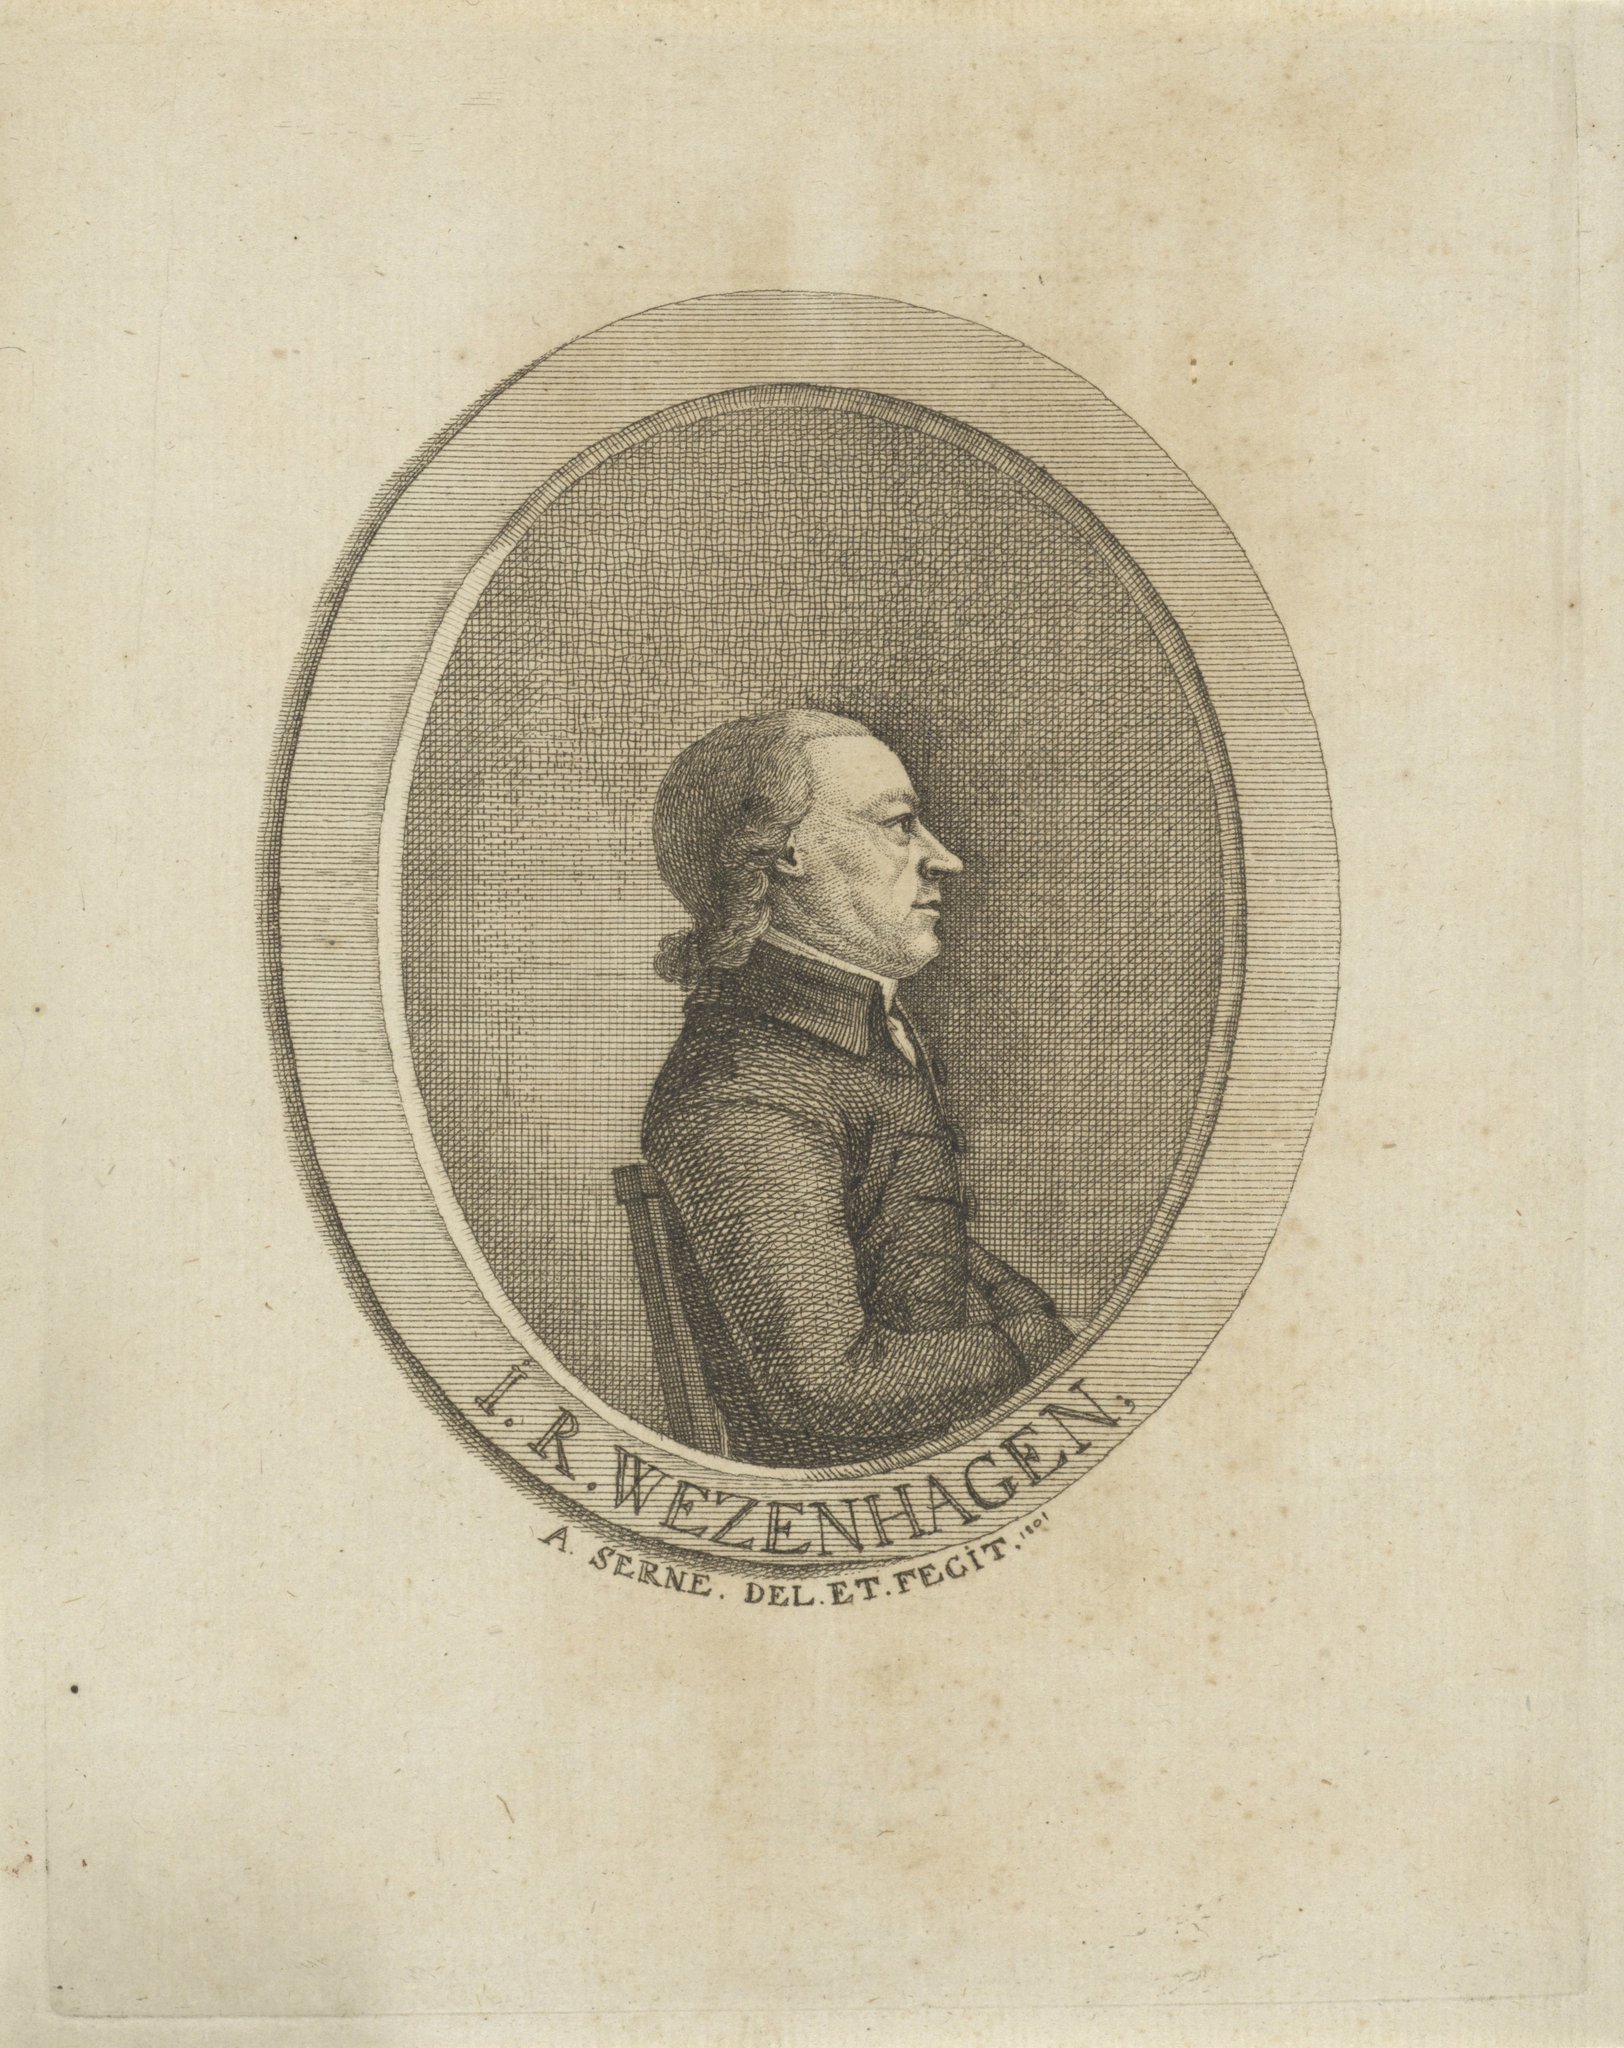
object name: print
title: Portret van predikant in opleiding Jan Reinier Wezenhagen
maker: adrianus serné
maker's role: print maker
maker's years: 1773-1853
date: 1801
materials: paper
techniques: engraving, etching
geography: haarlem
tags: jan reinier wezenhagen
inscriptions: collector's mark: Lugt 2228